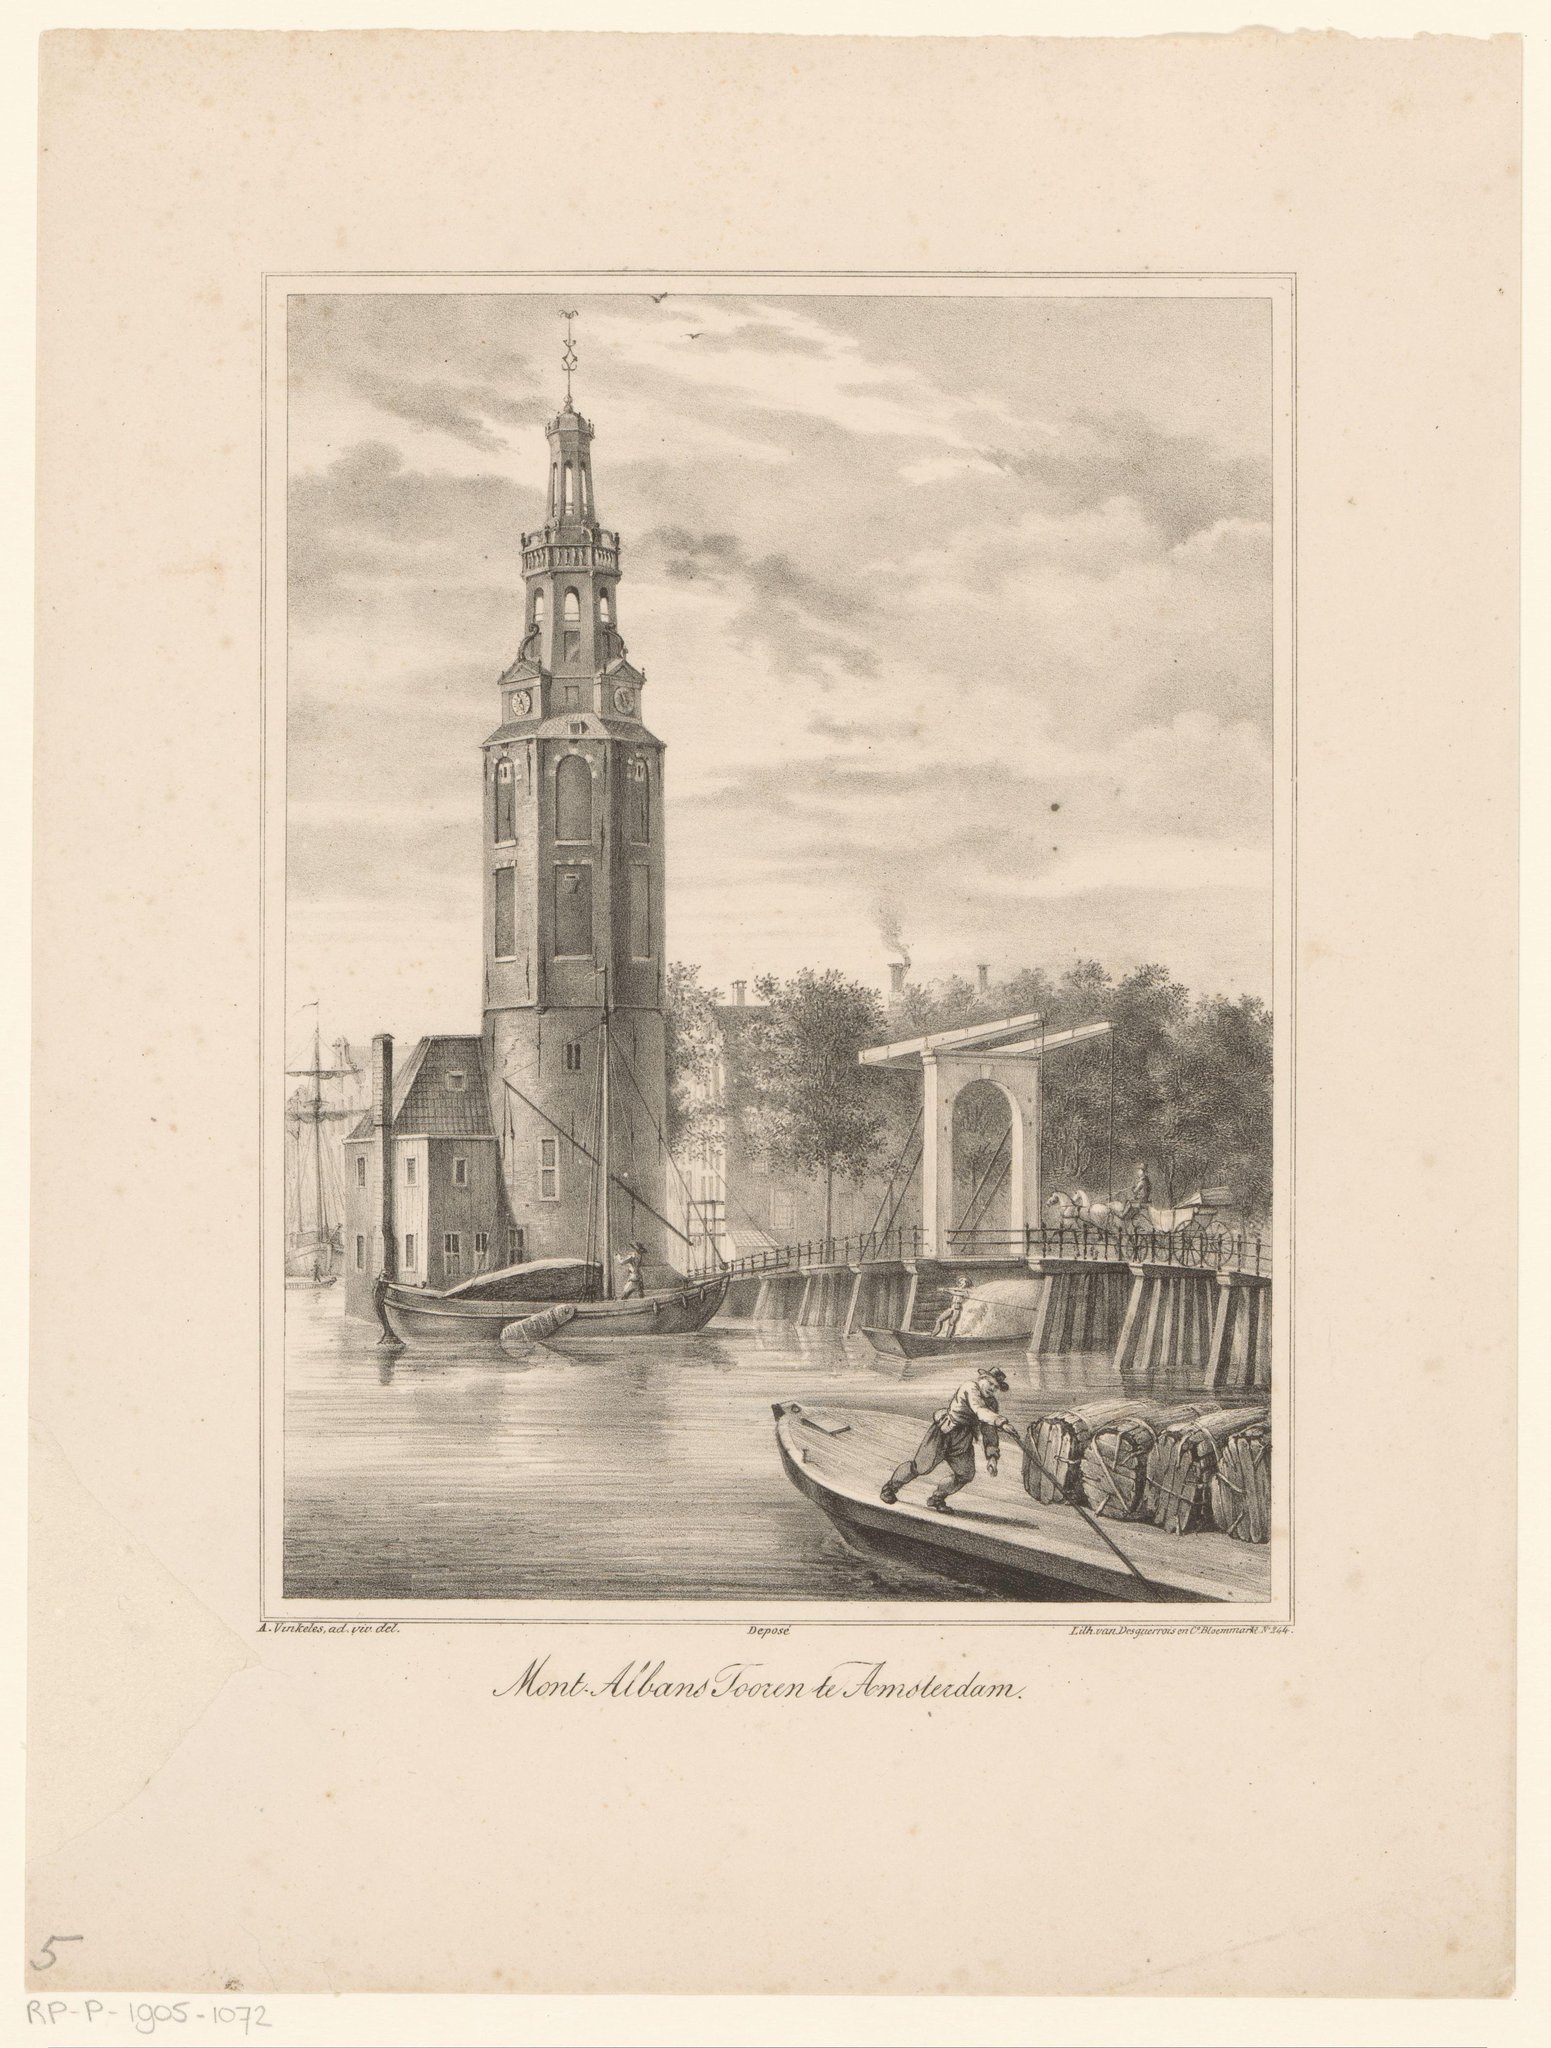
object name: print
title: Gezichten van de Zes Voornaamste Torens der Stad Amsterdam. 2de Cahier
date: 1828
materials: paper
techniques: lithograph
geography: amsterdam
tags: tower, clock tower ~ monumental adornment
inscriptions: : ‘Déposé.’, collector's mark: Lugt 2228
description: Prent is onderdeel van een serie van zes.